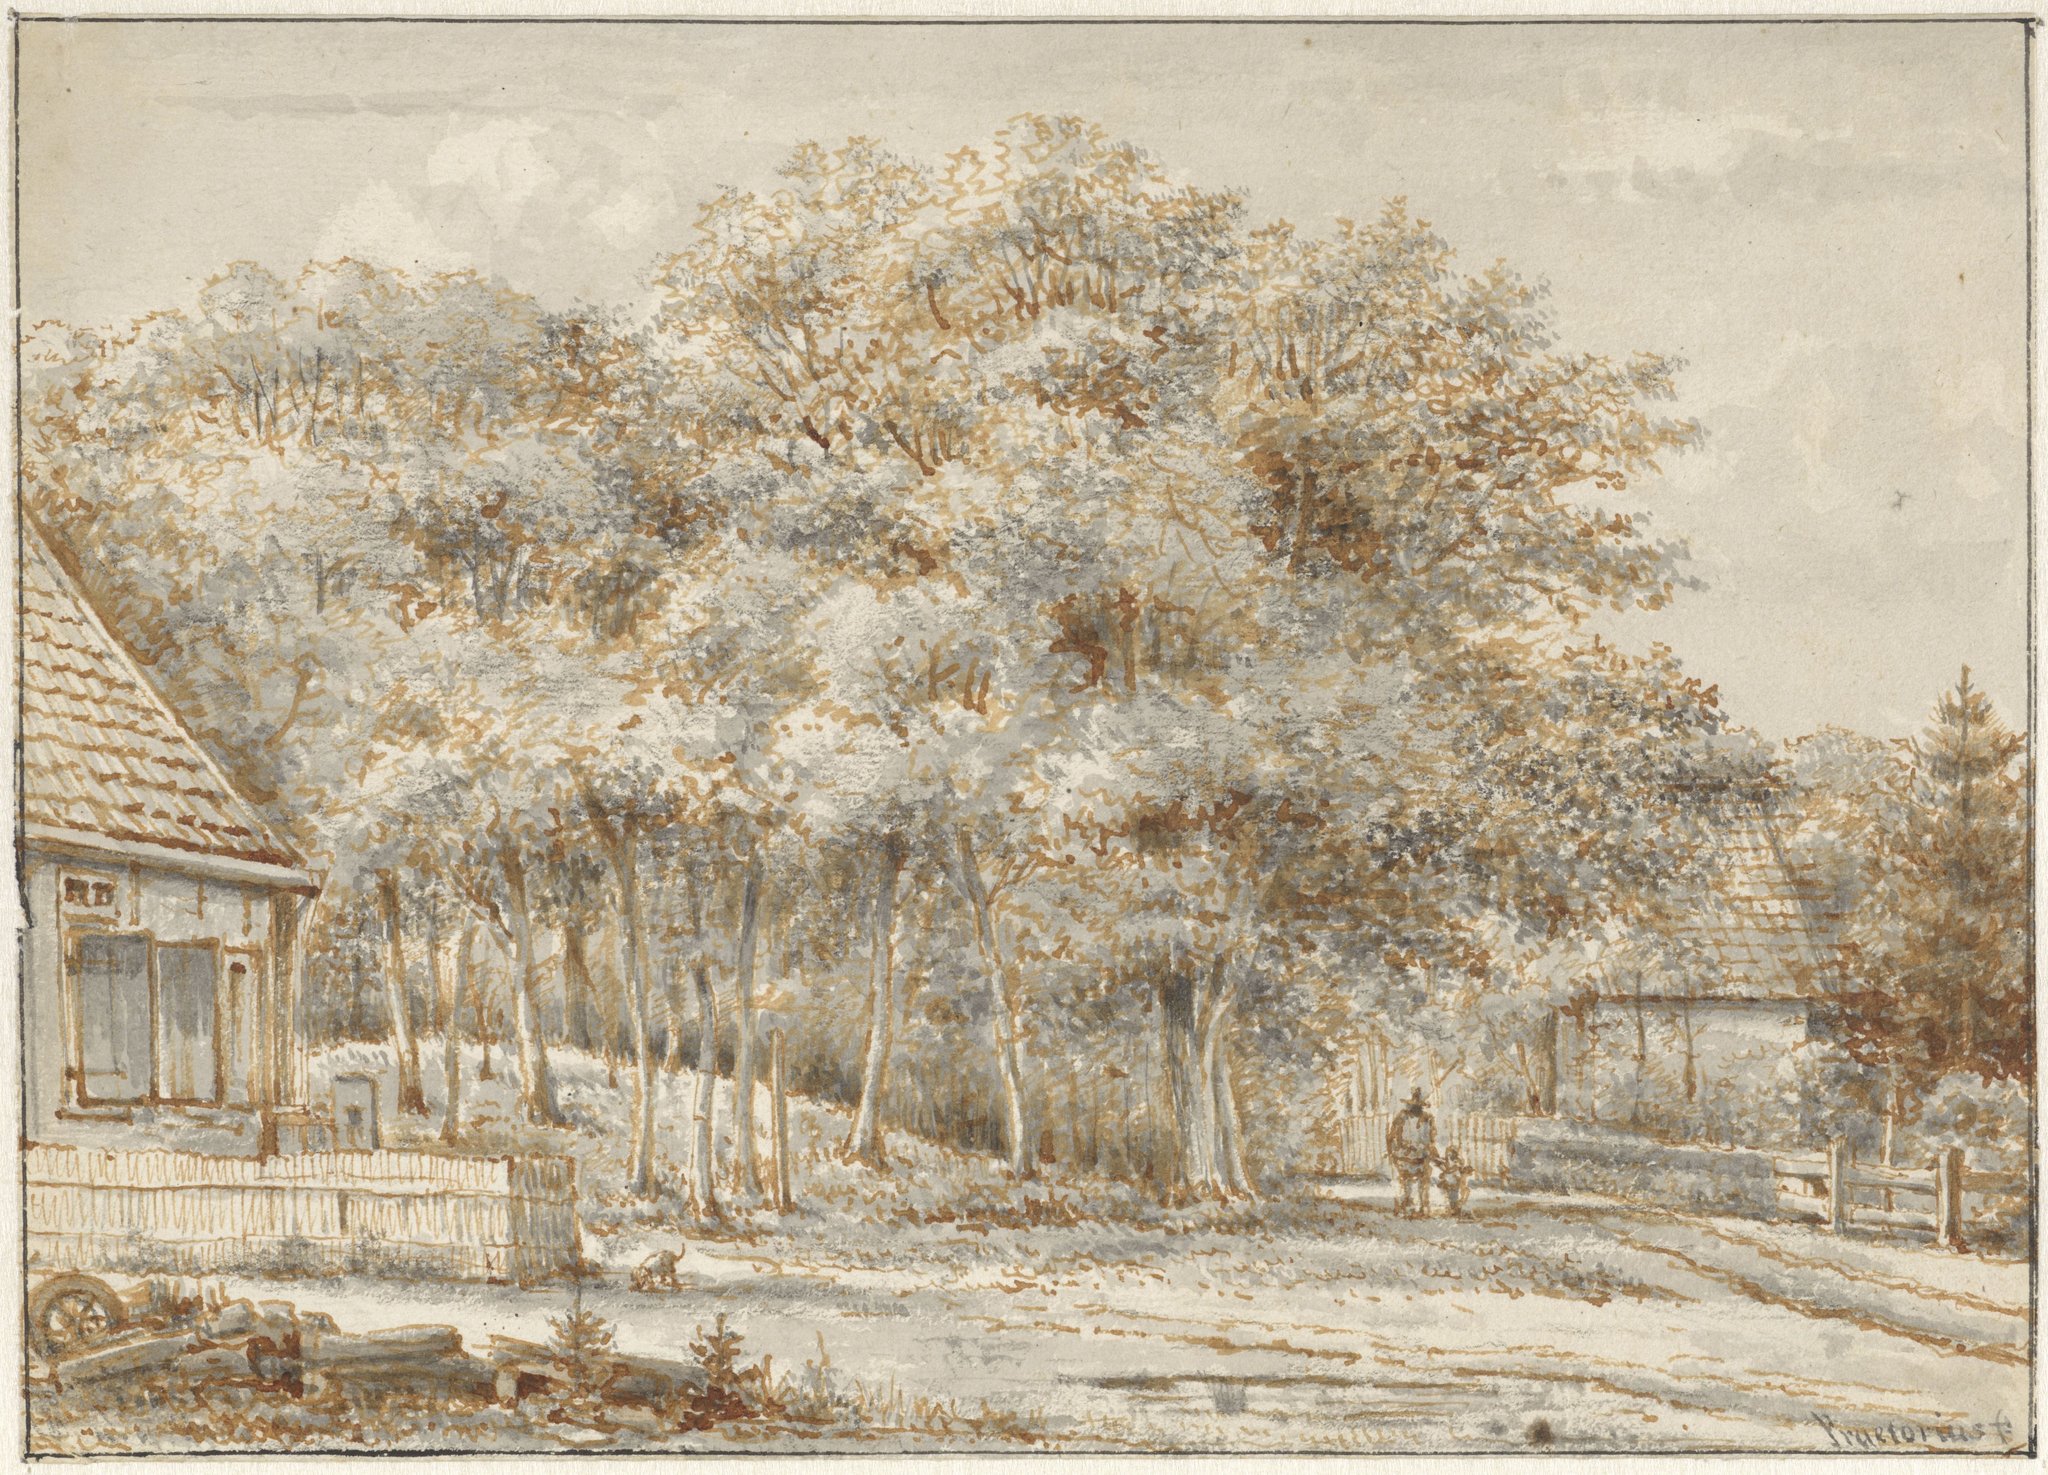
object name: drawing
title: Bosweg met twee huizen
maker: pieter ernst hendrik praetorius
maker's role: draughtsman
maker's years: 1791-1876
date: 1801-1876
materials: chalk, ink, paper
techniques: brush, pen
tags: trees, farm or solitary house in landscape